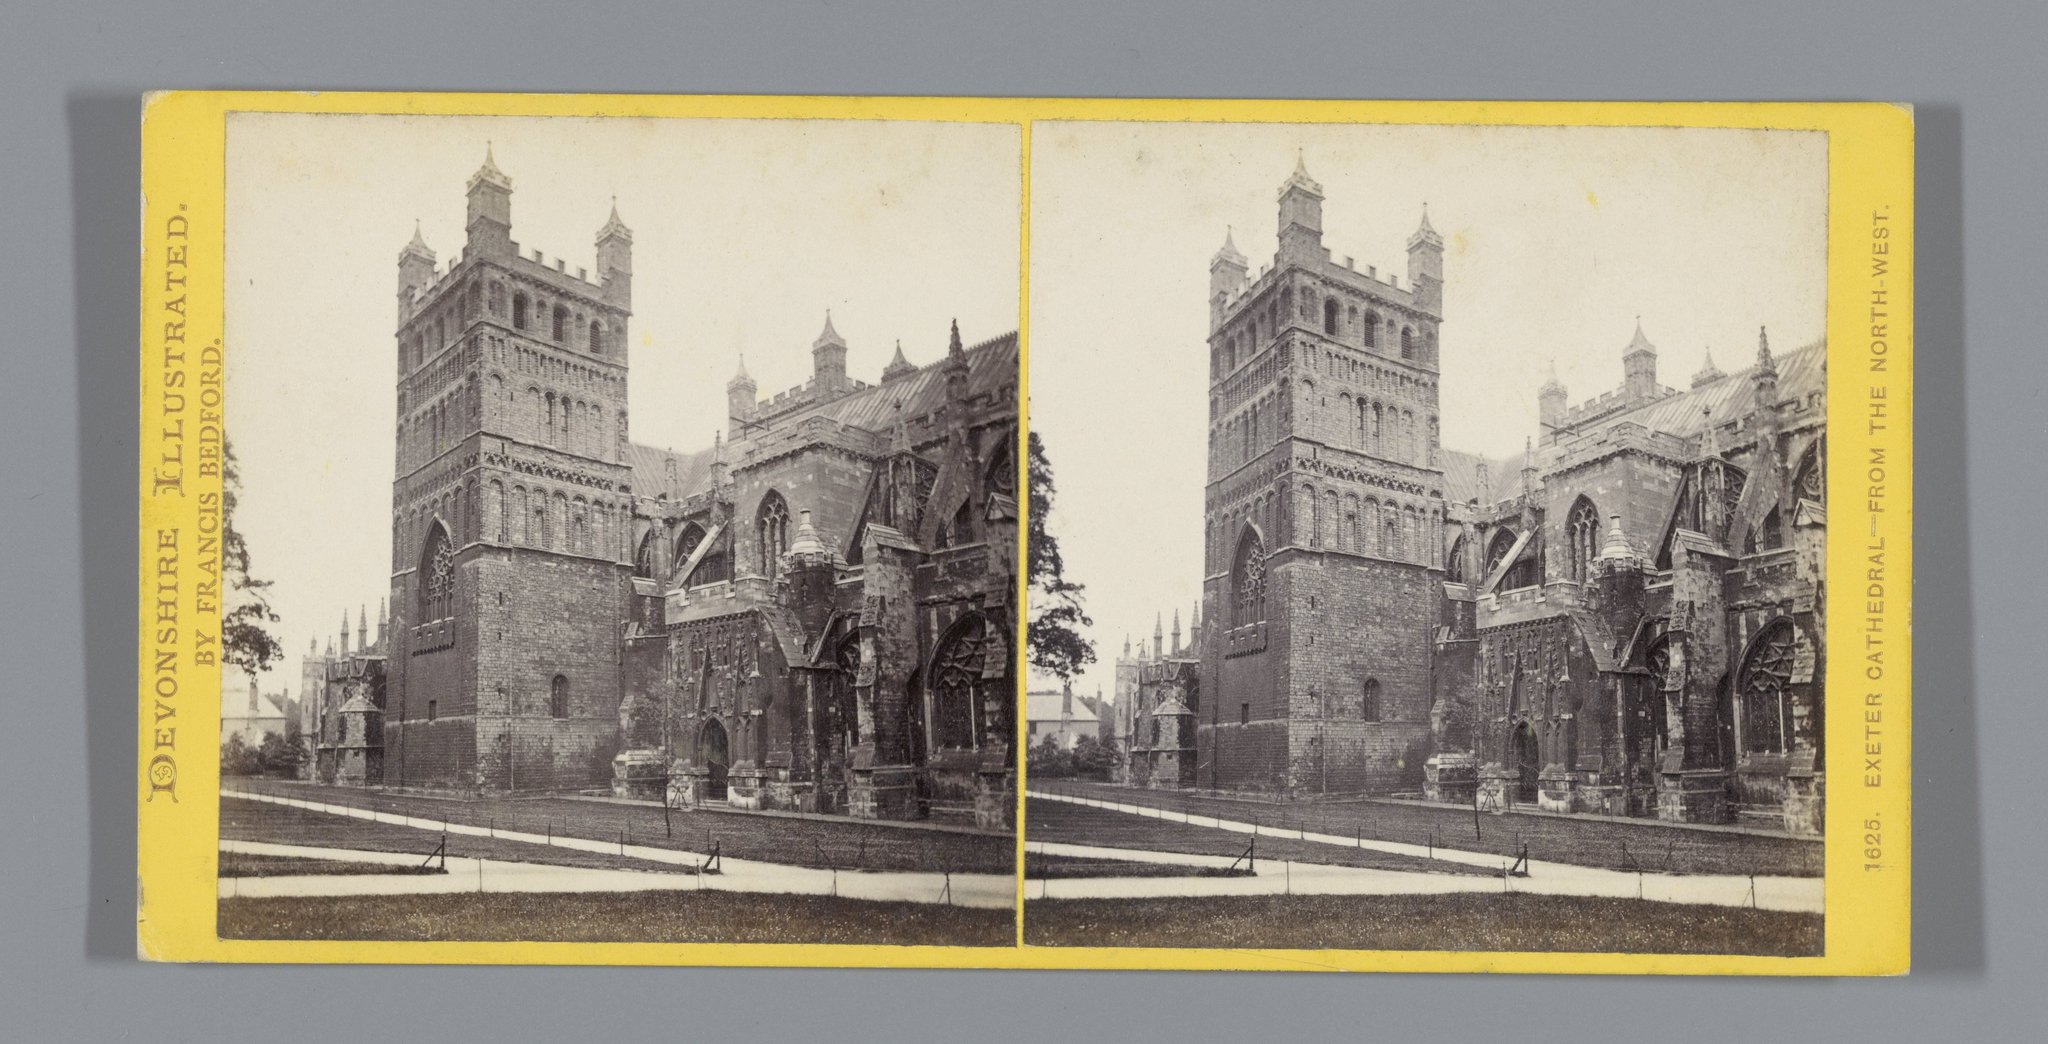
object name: stereograph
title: Exeter Cathedral-From the north-west.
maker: francis bedford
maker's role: print maker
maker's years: 1815-1894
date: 1850-1880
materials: cardboard, photographic support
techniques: albumen print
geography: exeter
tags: church (exterior), parts of church exterior and annexes: tower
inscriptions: number: ‘1625.’, inscription: ‘Devonshire Illustrated. by Francis Bedford.’